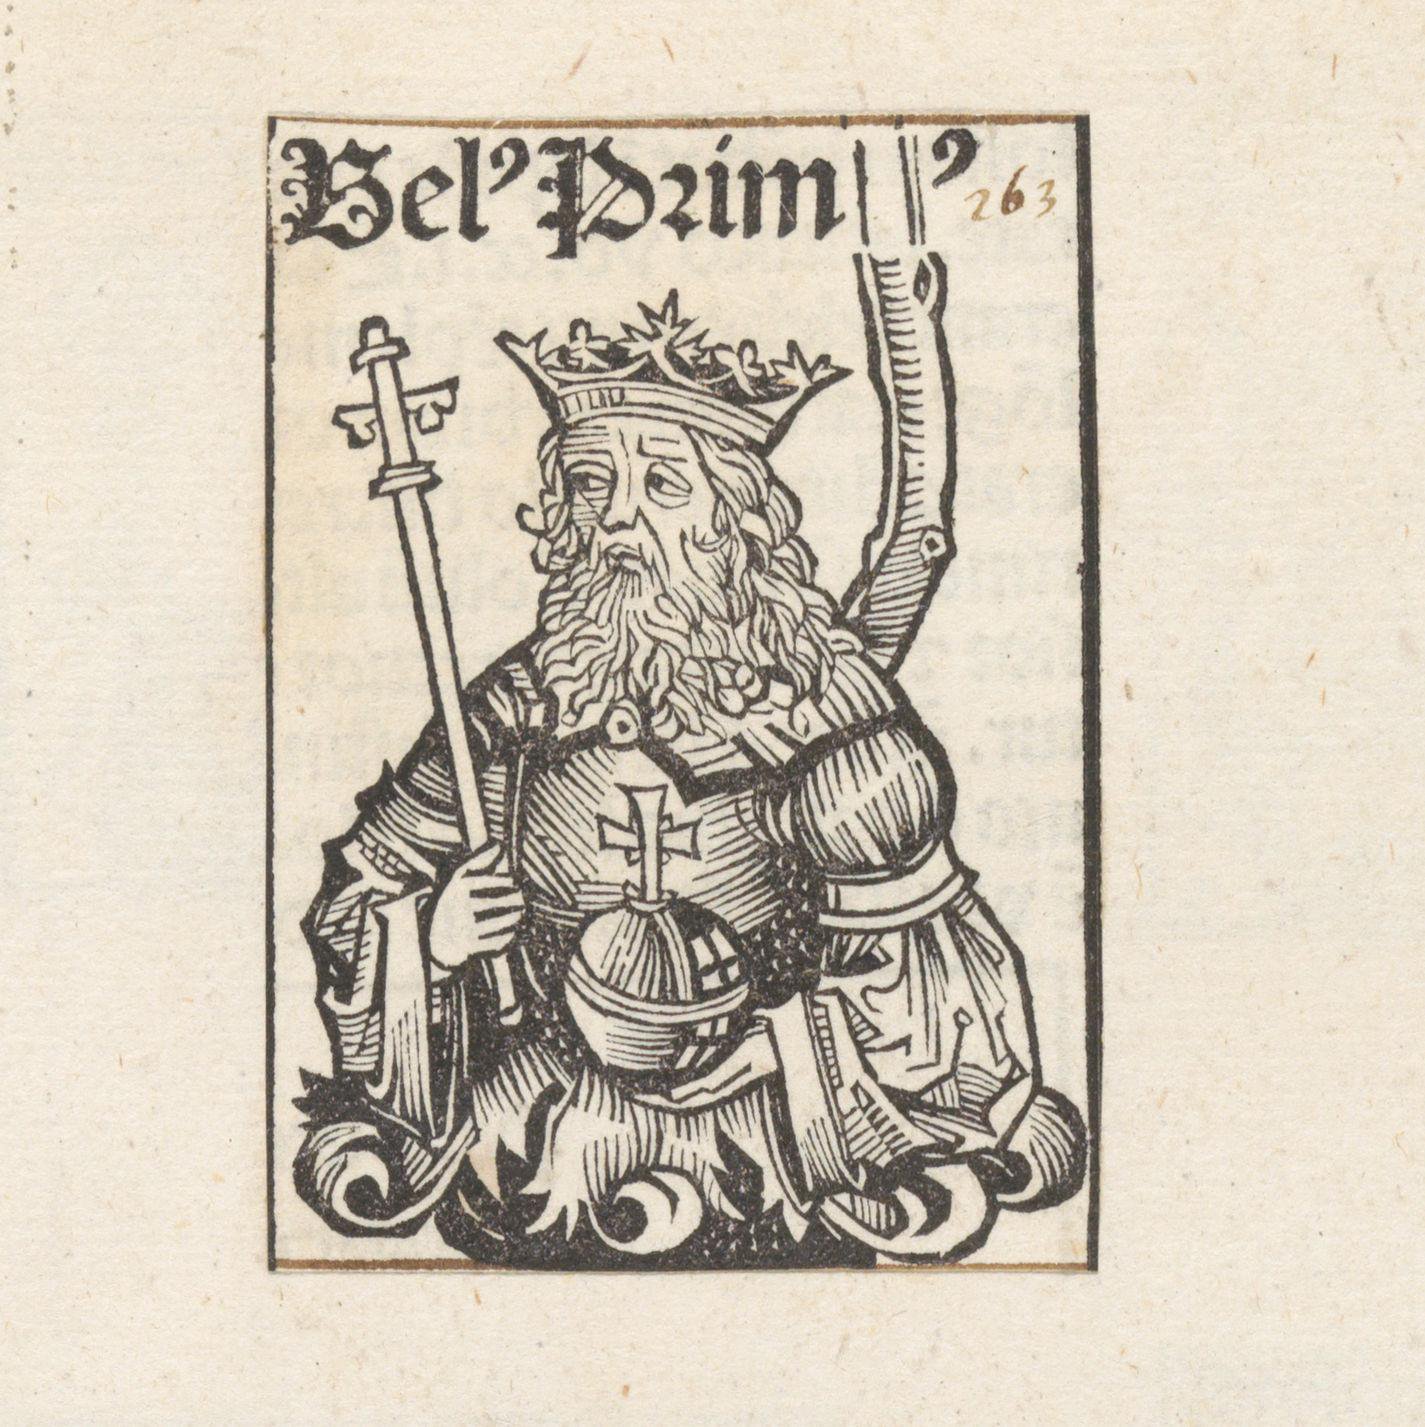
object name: print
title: Liber Chronicarum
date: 1493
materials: paper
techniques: letterpress printing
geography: nuremberg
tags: king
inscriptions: inscription: ‘263’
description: Een bloemkelk waarin een koning met scepter en rijksappel, naar links gekeerd. De tekst identificeert hem als de Assyrische koning Belus. De voorstelling is een onderdeel van de opeenvolging van Assyrische koningen in de Liber Chronicarum. De prent maakt deel uit van een album.